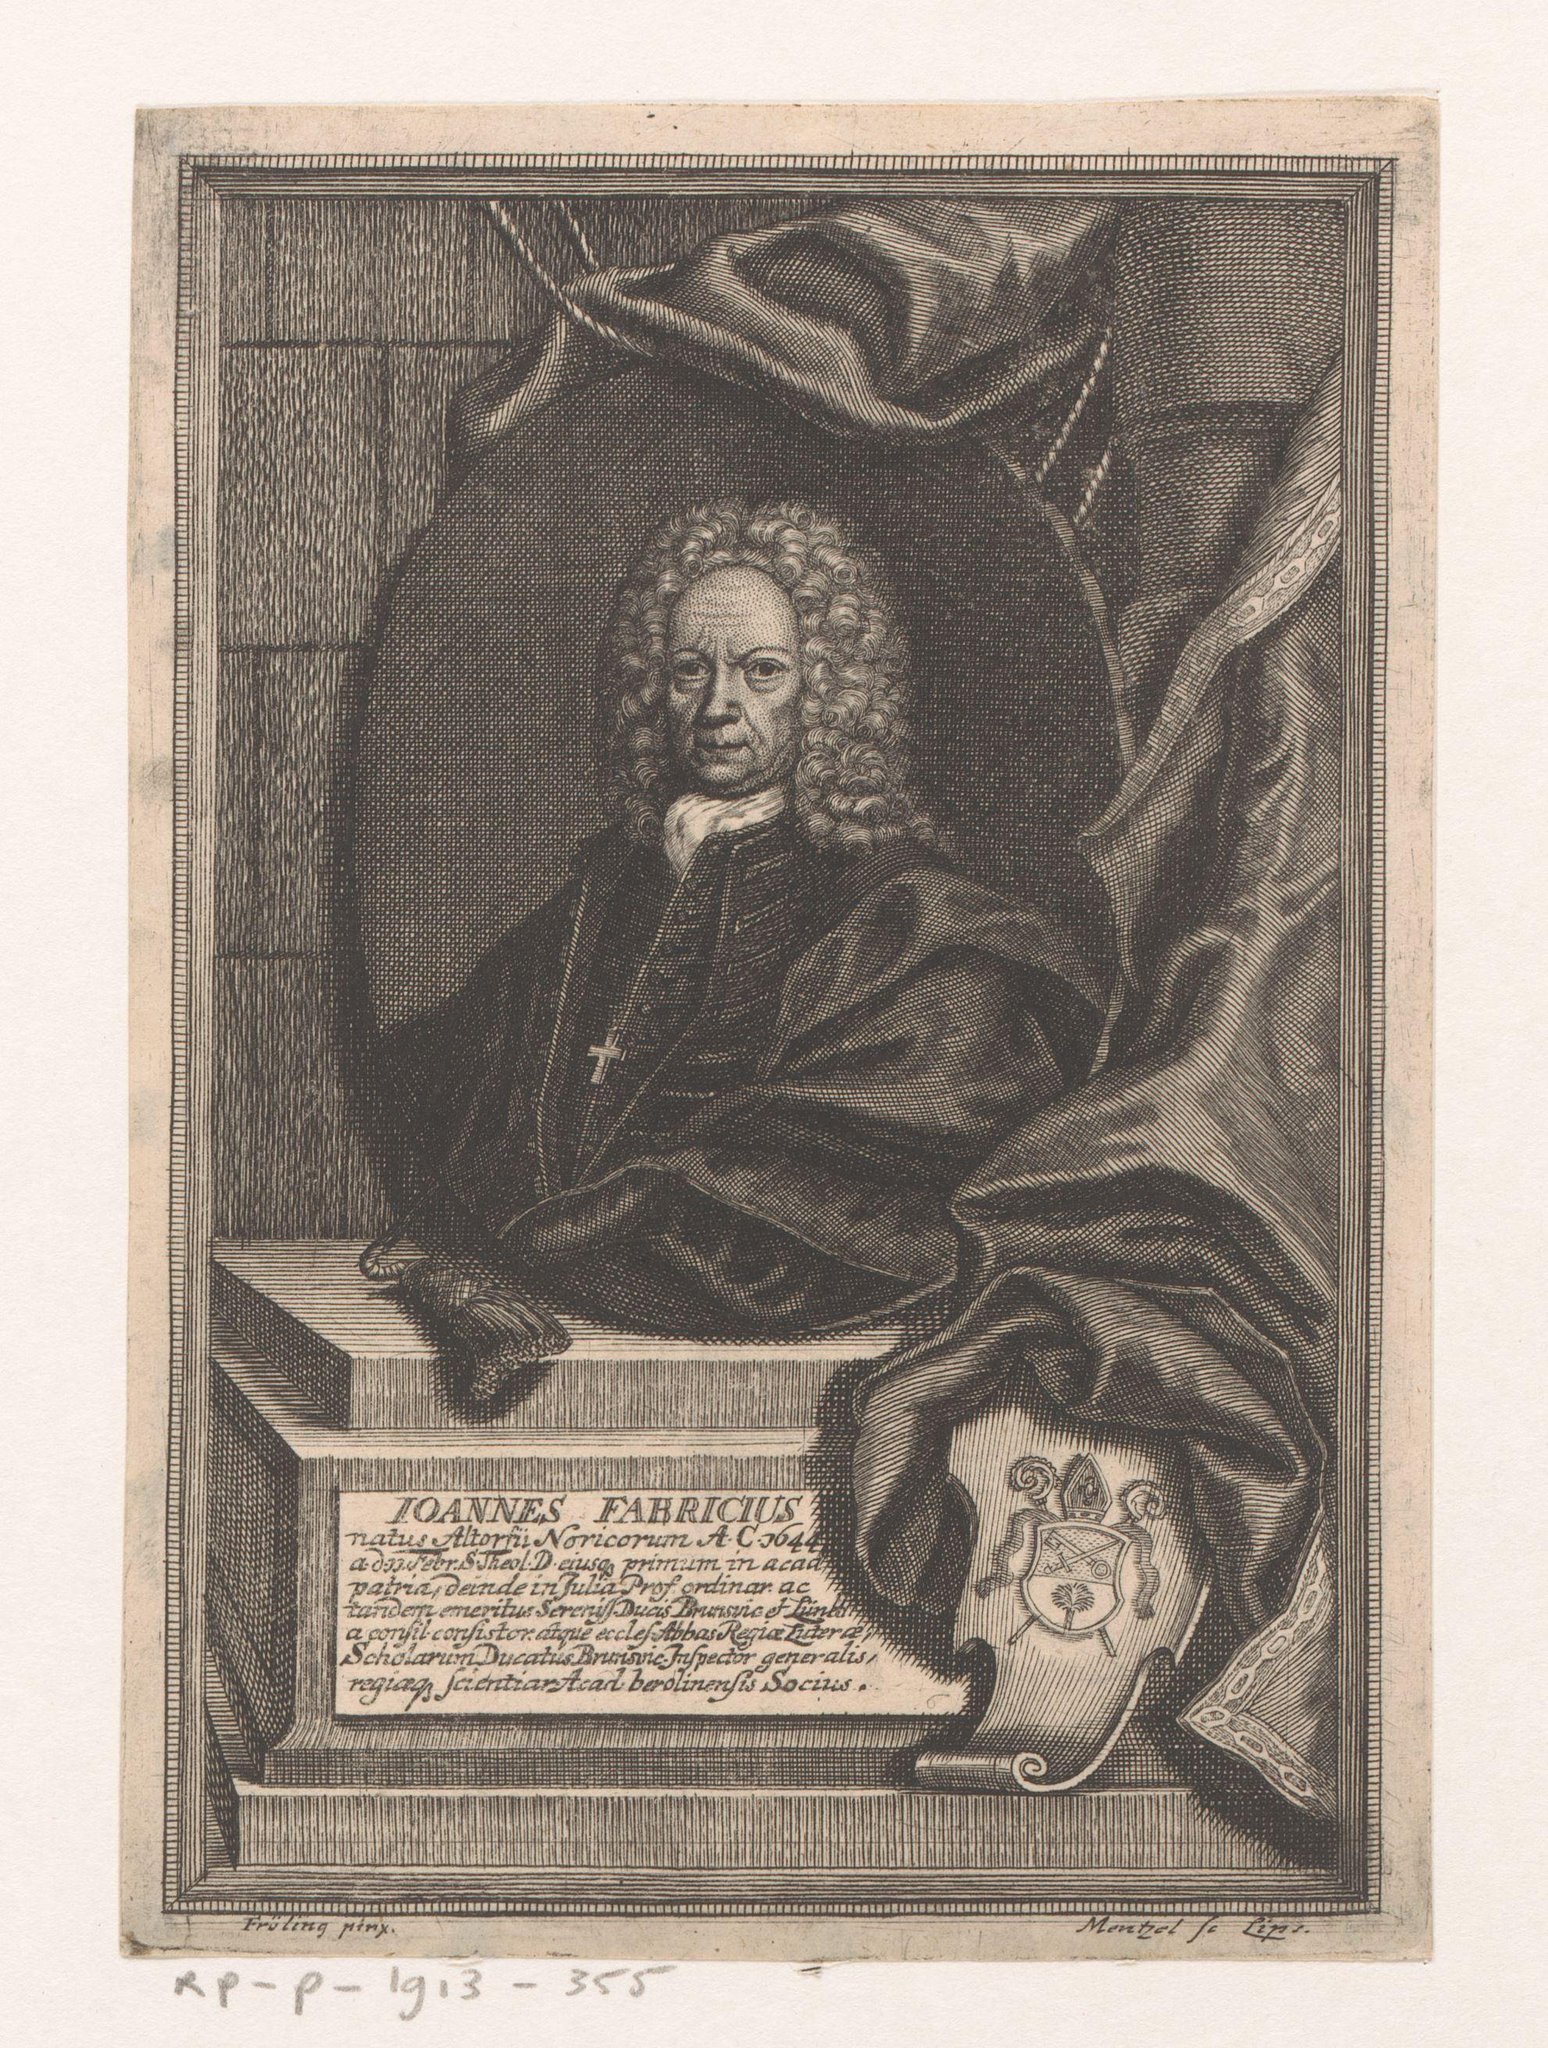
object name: print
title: Portret van Johann Fabricius (IV)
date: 1687-1743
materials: paper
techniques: engraving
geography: leipzig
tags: historical persons, crucifix ~ personal devotion, wig, armorial bearing, heraldry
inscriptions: collector's mark: Lugt 2228